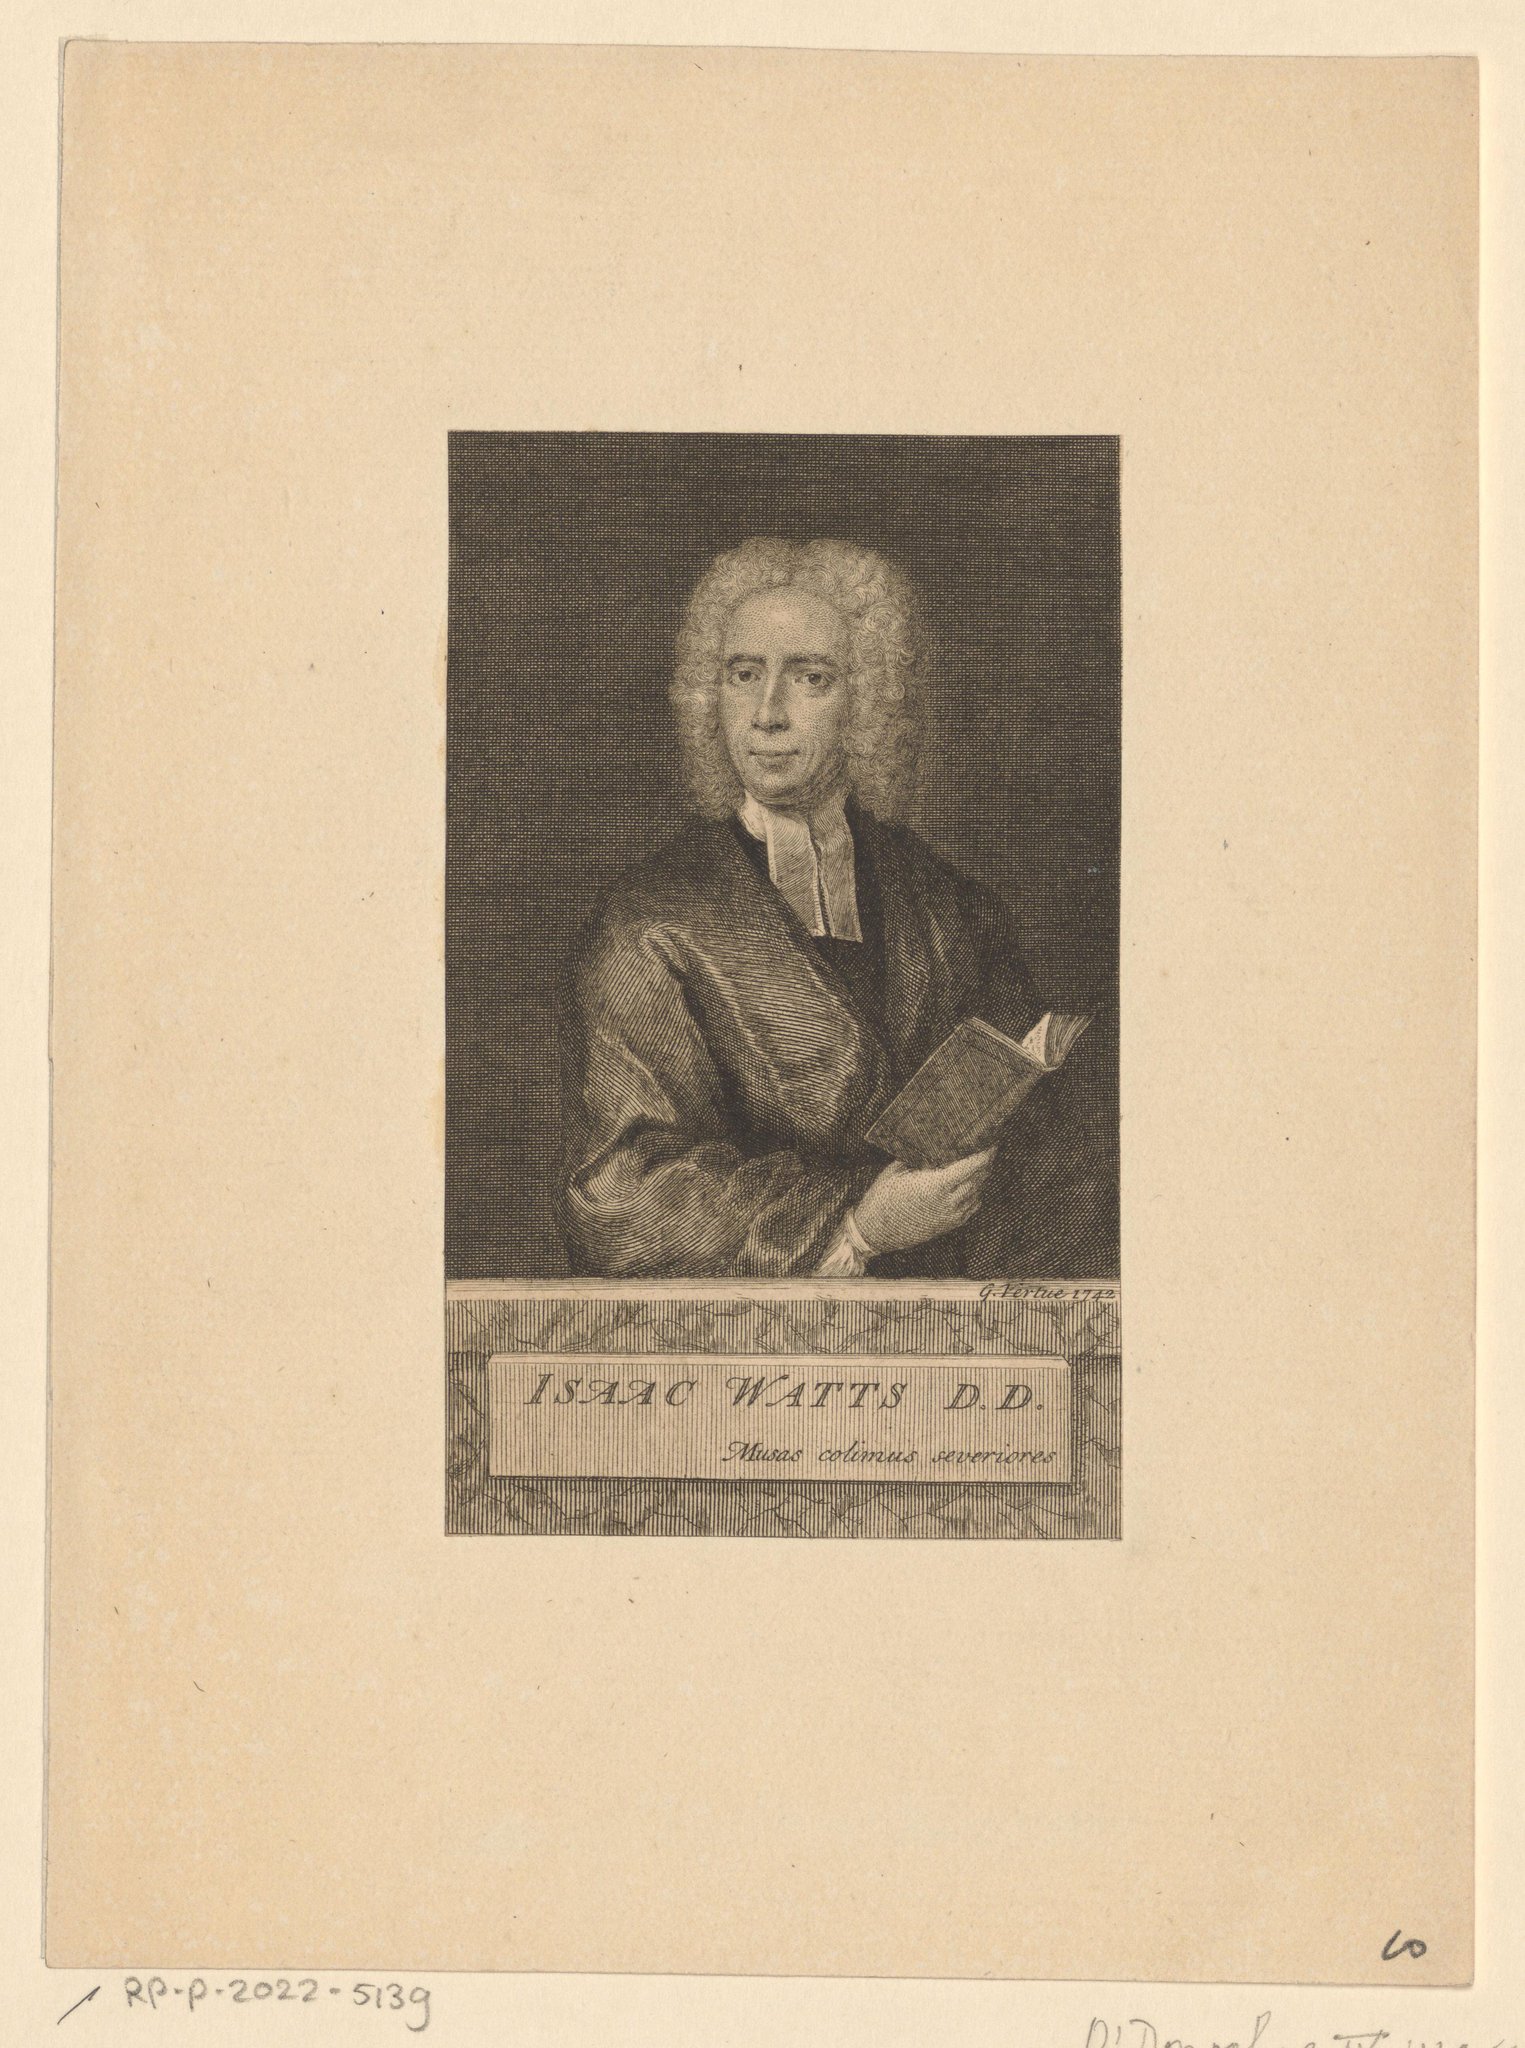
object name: print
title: Portret van Isaac Watts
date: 1742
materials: paper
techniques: engraving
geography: london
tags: theologian, historical persons, portrait of a writer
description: Volgens O'Donoghue is de prent mogelijk gebruikt in een uitgave van Watt's Horae Lyricae.